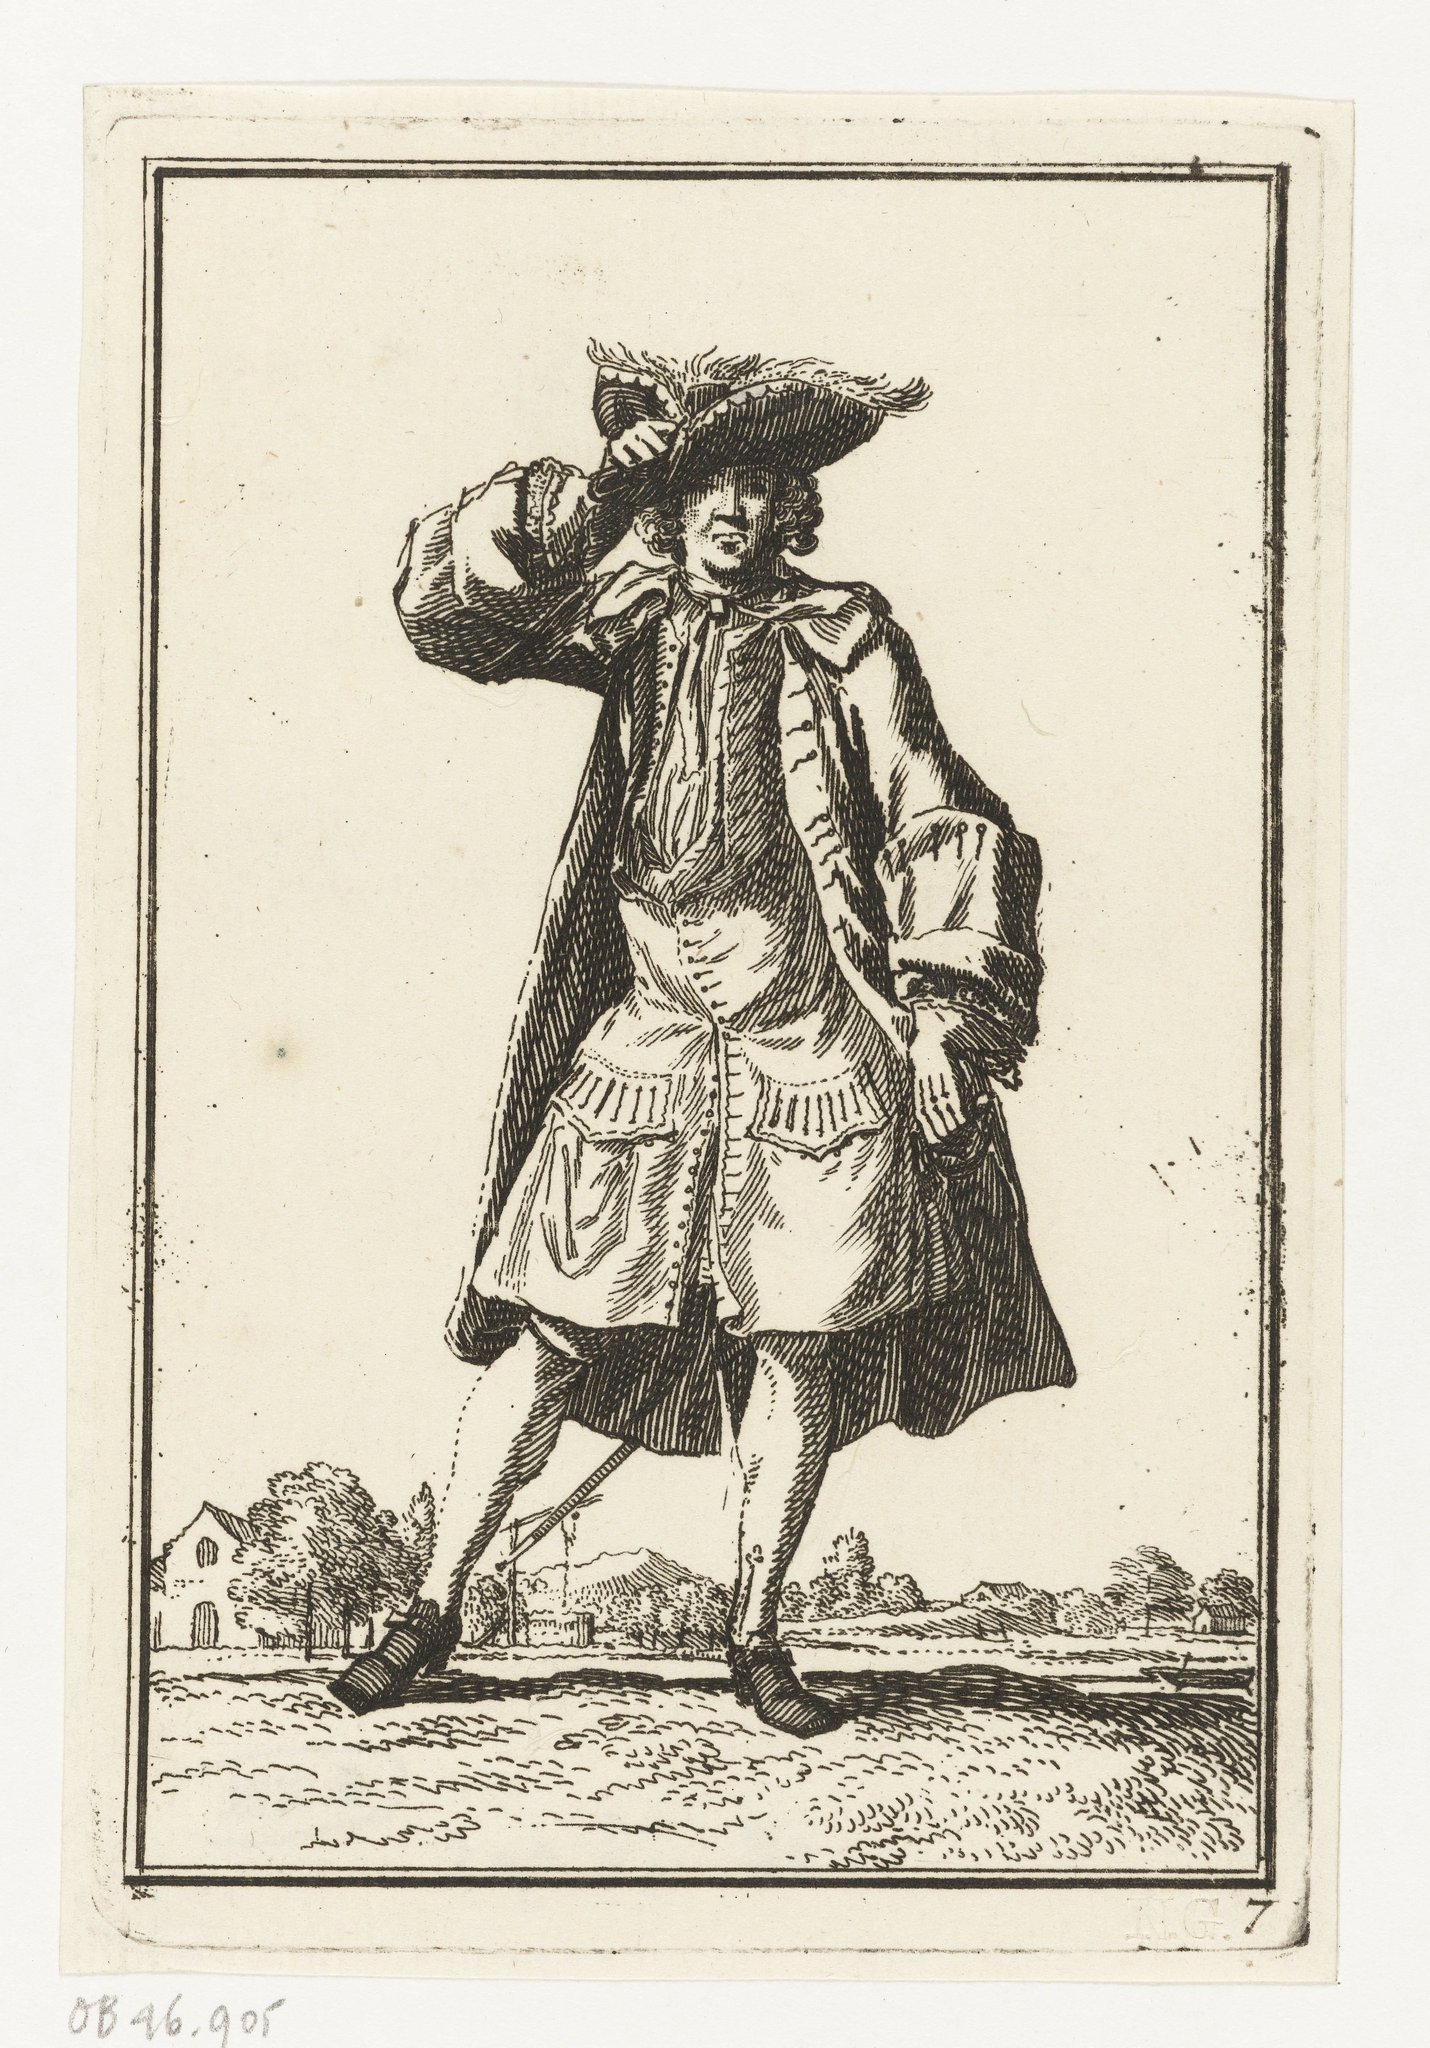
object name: costume print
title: Man die zijn hoed afneemt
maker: adolf van der laan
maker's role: draughtsman, print maker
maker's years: 1689-1742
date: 1710-1755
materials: paper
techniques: etching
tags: europeans (with name) (+ costume), clothes, costume (+ men's clothes)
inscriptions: collector's mark: Lugt 2228, collector's mark: Lugt 1967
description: Man in een landschap, gekleed volgens de Hollandse mode van 1710-1720. Ten voeten uit en zijn hoed afnemend. De prent maakt deel uit van een zestiendelige serie prenten met voorstellingen van Hollandse kostuums.